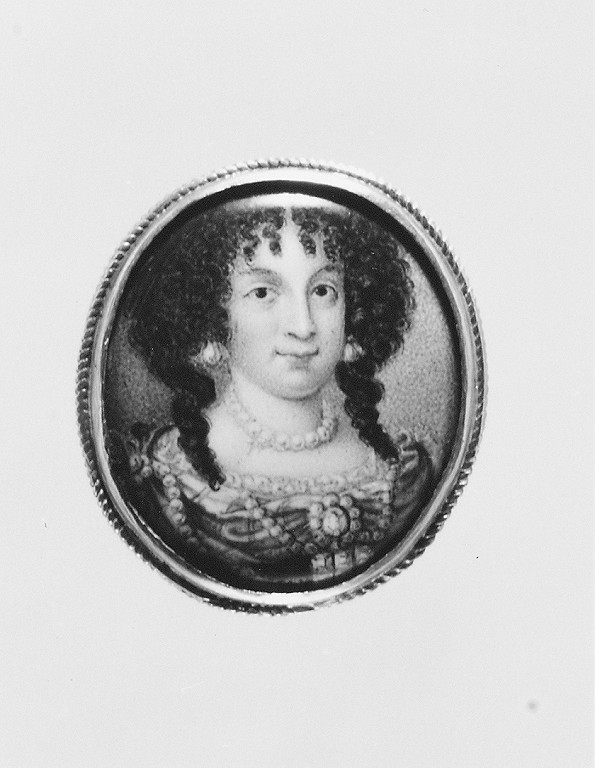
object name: painting, miniature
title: Portrait of a Woman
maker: continental painter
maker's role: artist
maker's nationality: continental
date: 1685-1695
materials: enamel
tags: portraits,women